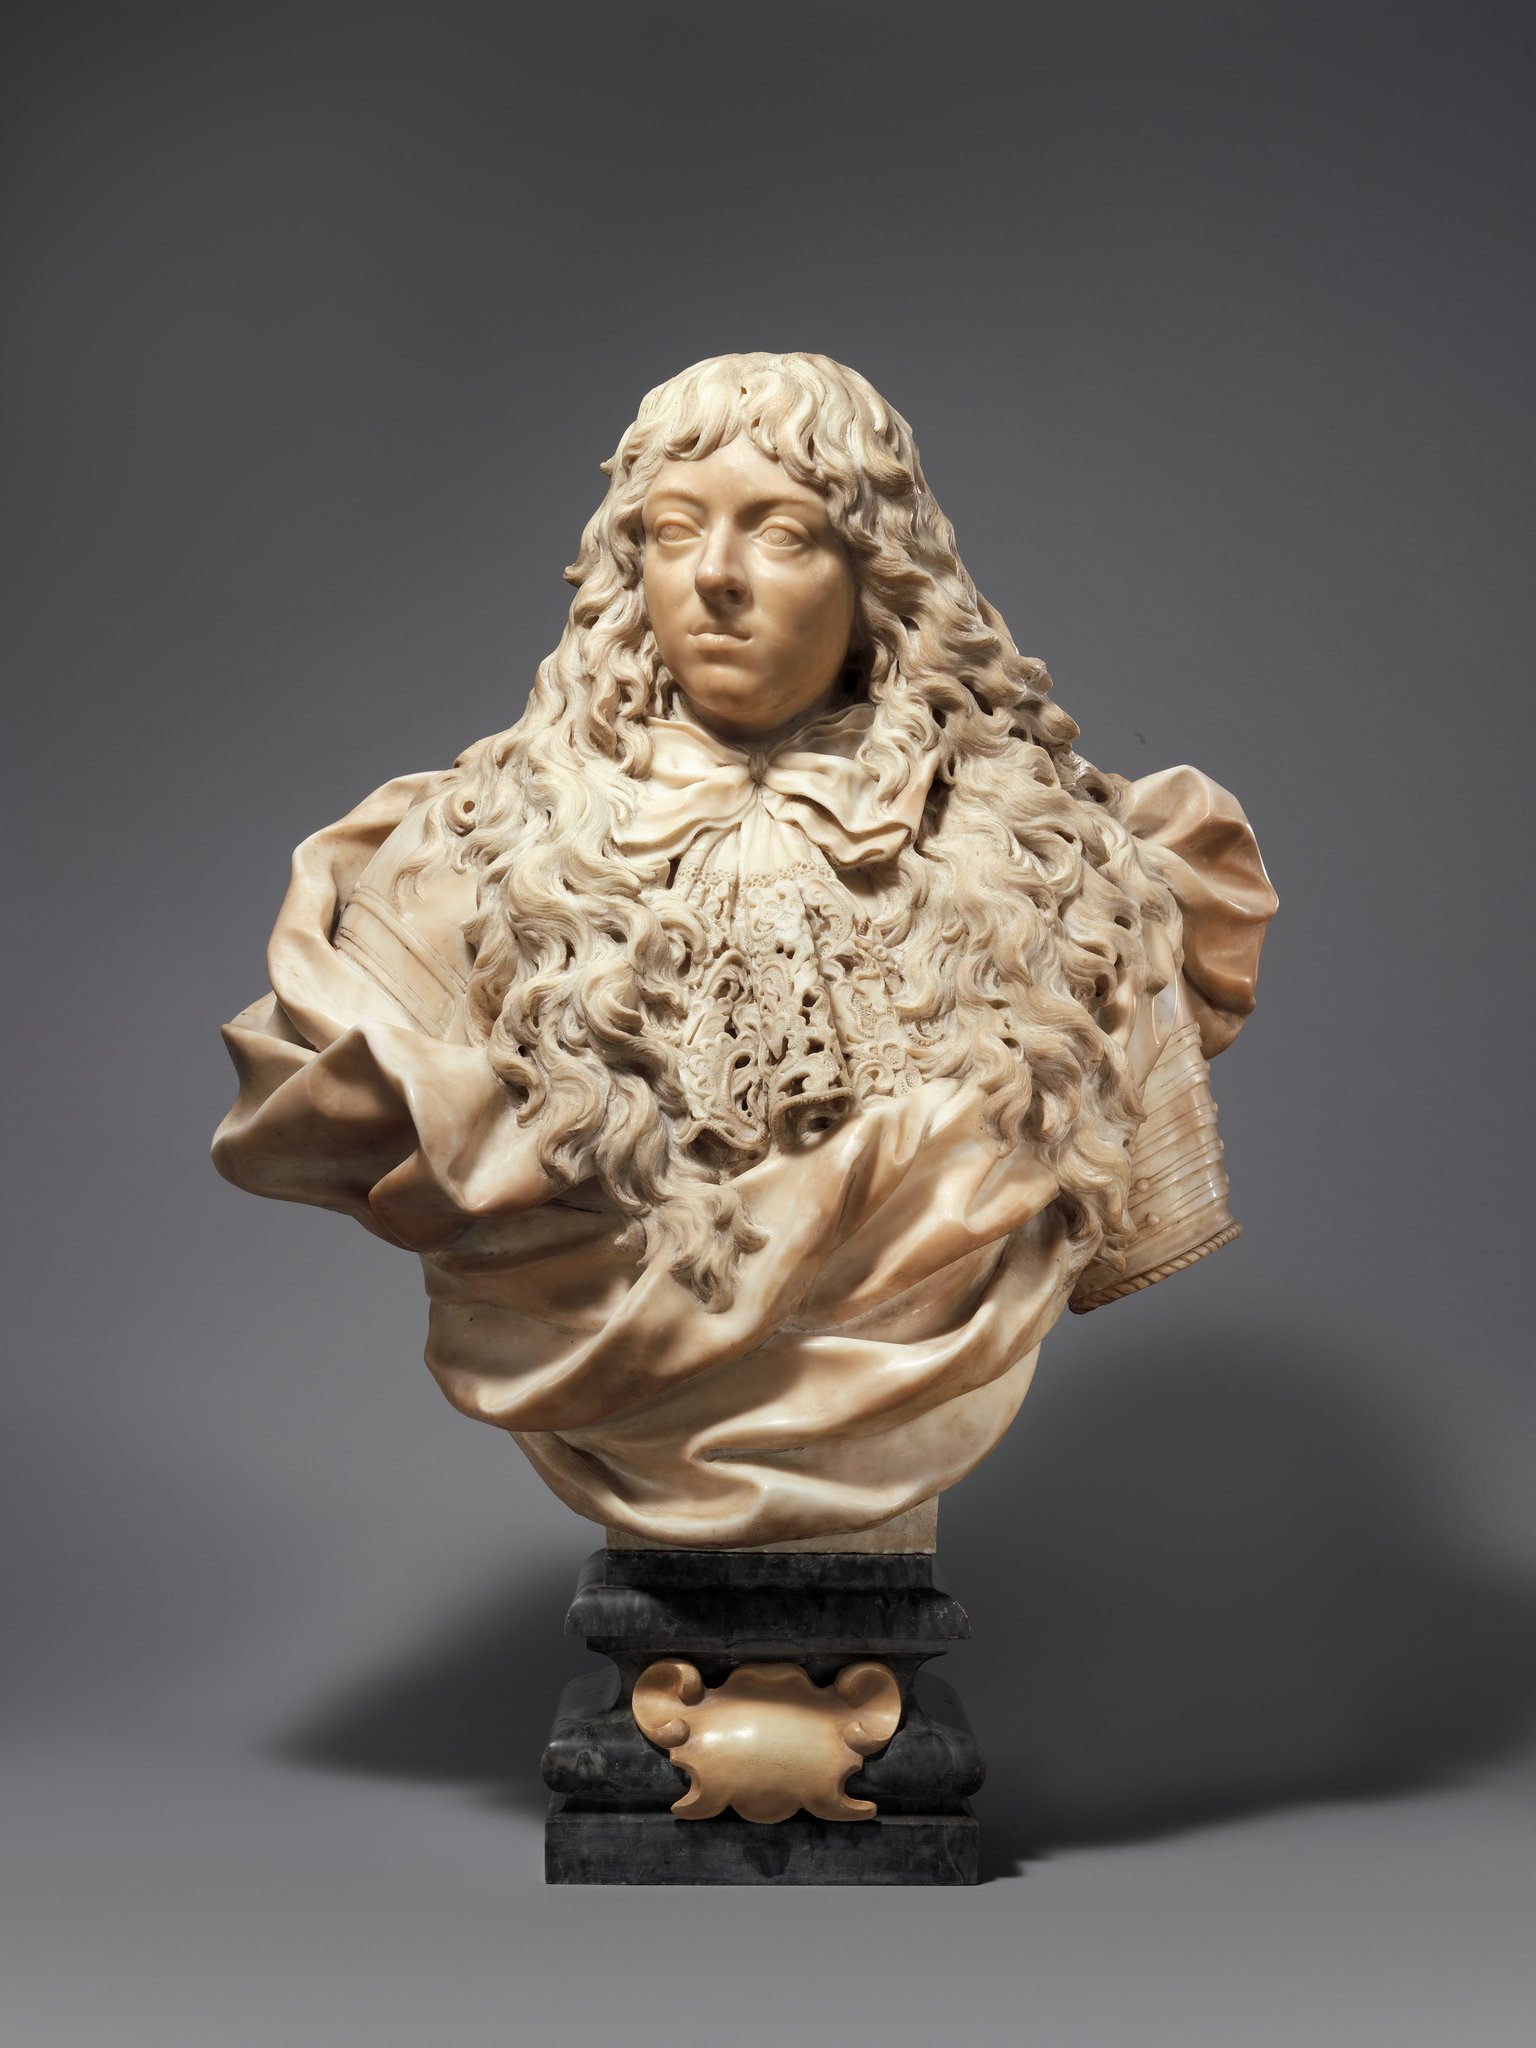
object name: bust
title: Ferdinando de' Medici, Grand Prince of Tuscany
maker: giovanni battista foggini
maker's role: artist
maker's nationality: italian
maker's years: 1652-1725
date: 1680-1682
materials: marble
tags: men,portraits